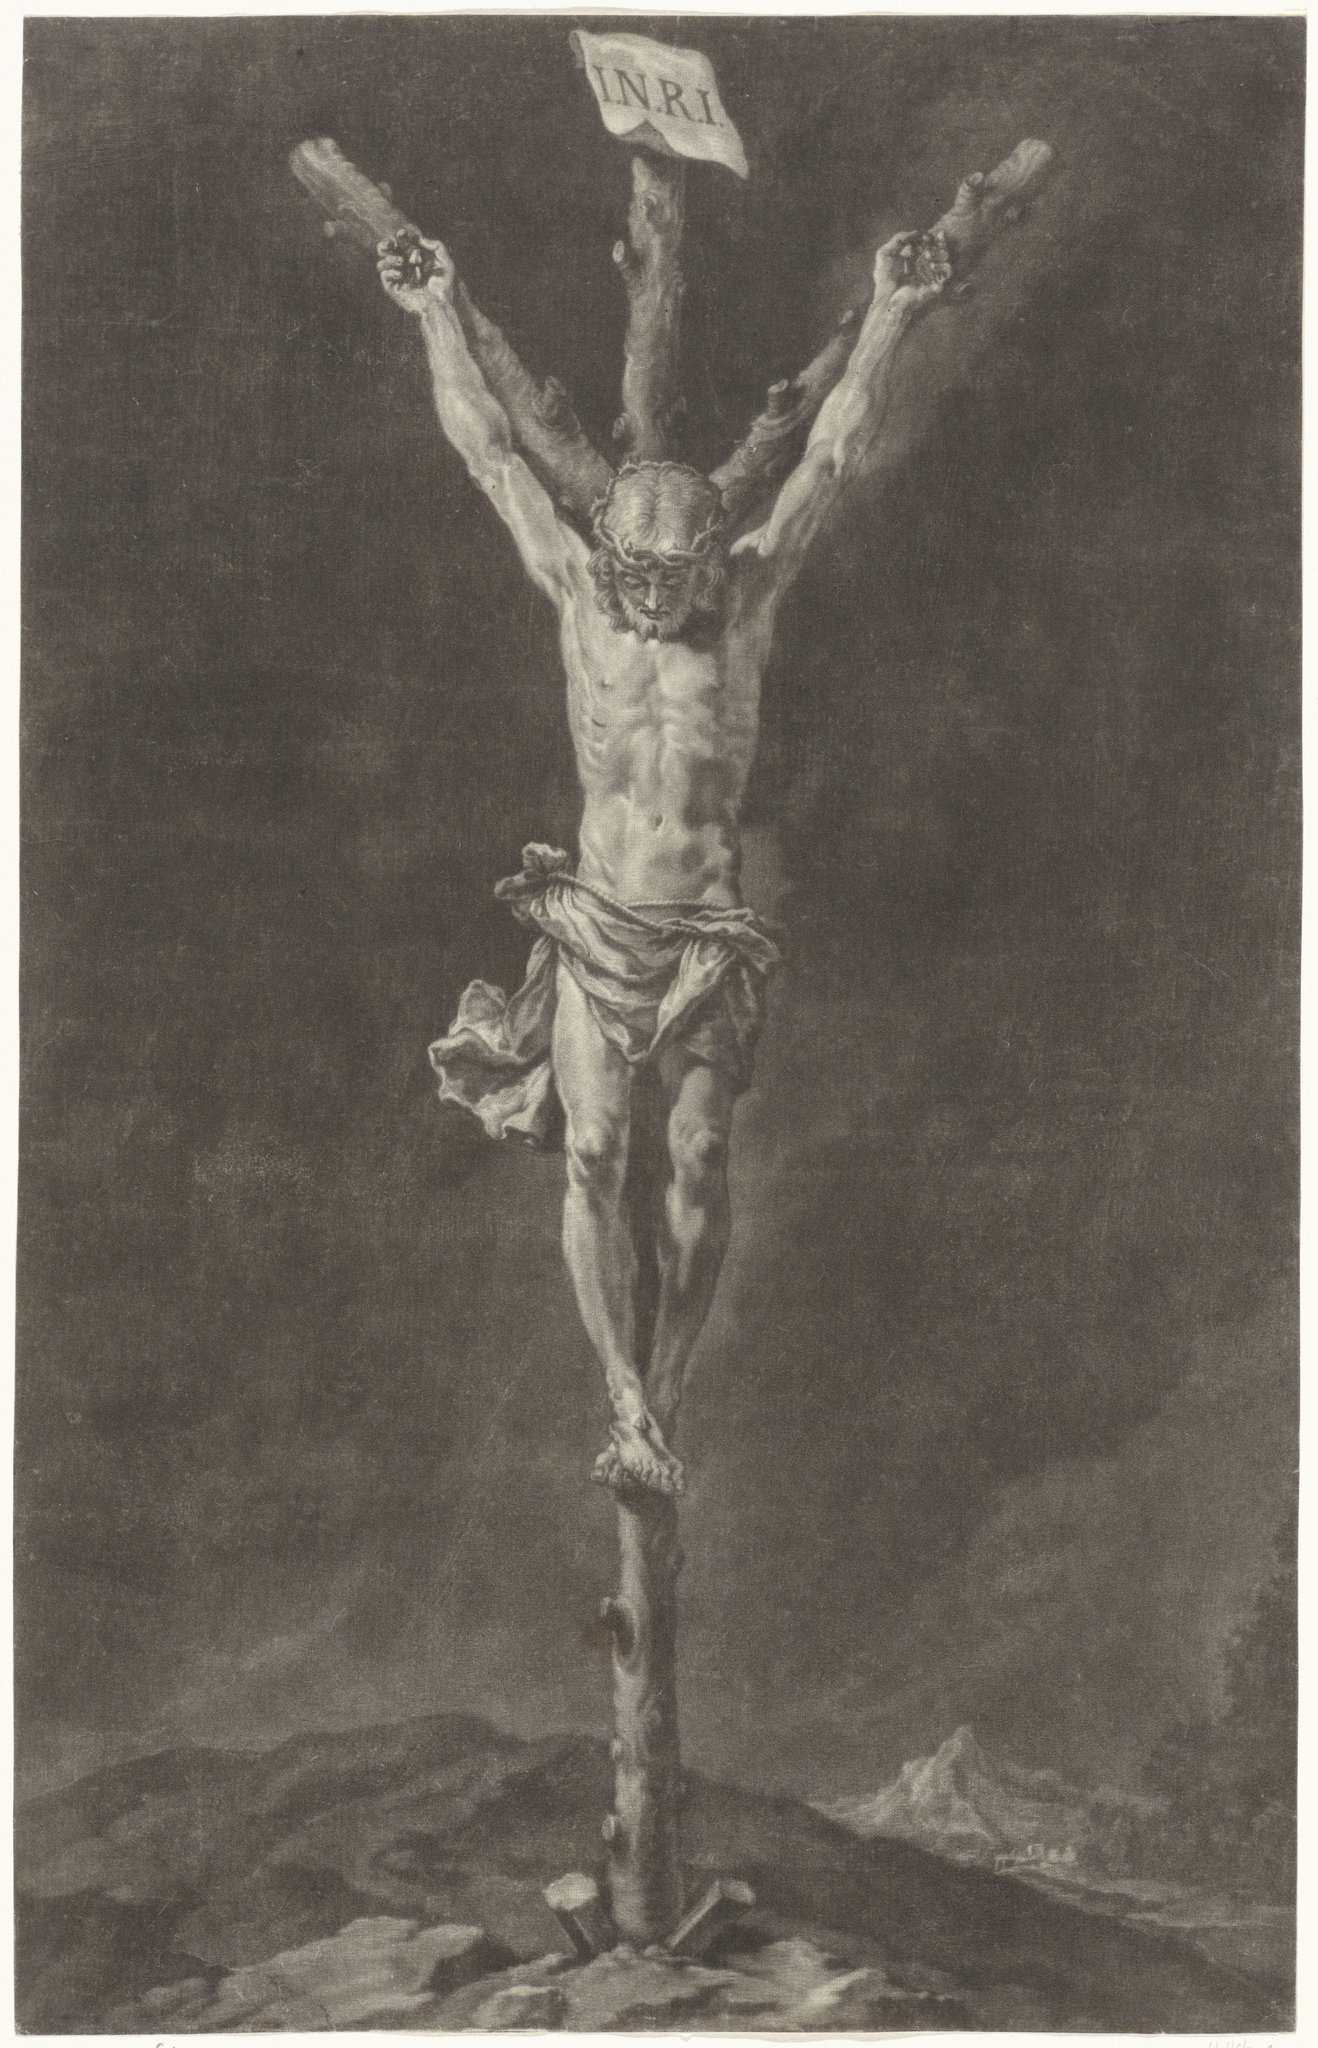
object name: print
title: Christus aan het kruis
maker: jan thomas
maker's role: print maker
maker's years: 1617-1678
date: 1642-1678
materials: paper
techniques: mezzotint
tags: the crucifixion of christ: christ's death on the cross; golgotha (matthew 27:45-58; mark 15:33-45; luke 23:44-52; john 19:25-38)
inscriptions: collector's mark: Lugt 2228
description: Christus aan het kruis, tegen een landschap met heuvels.